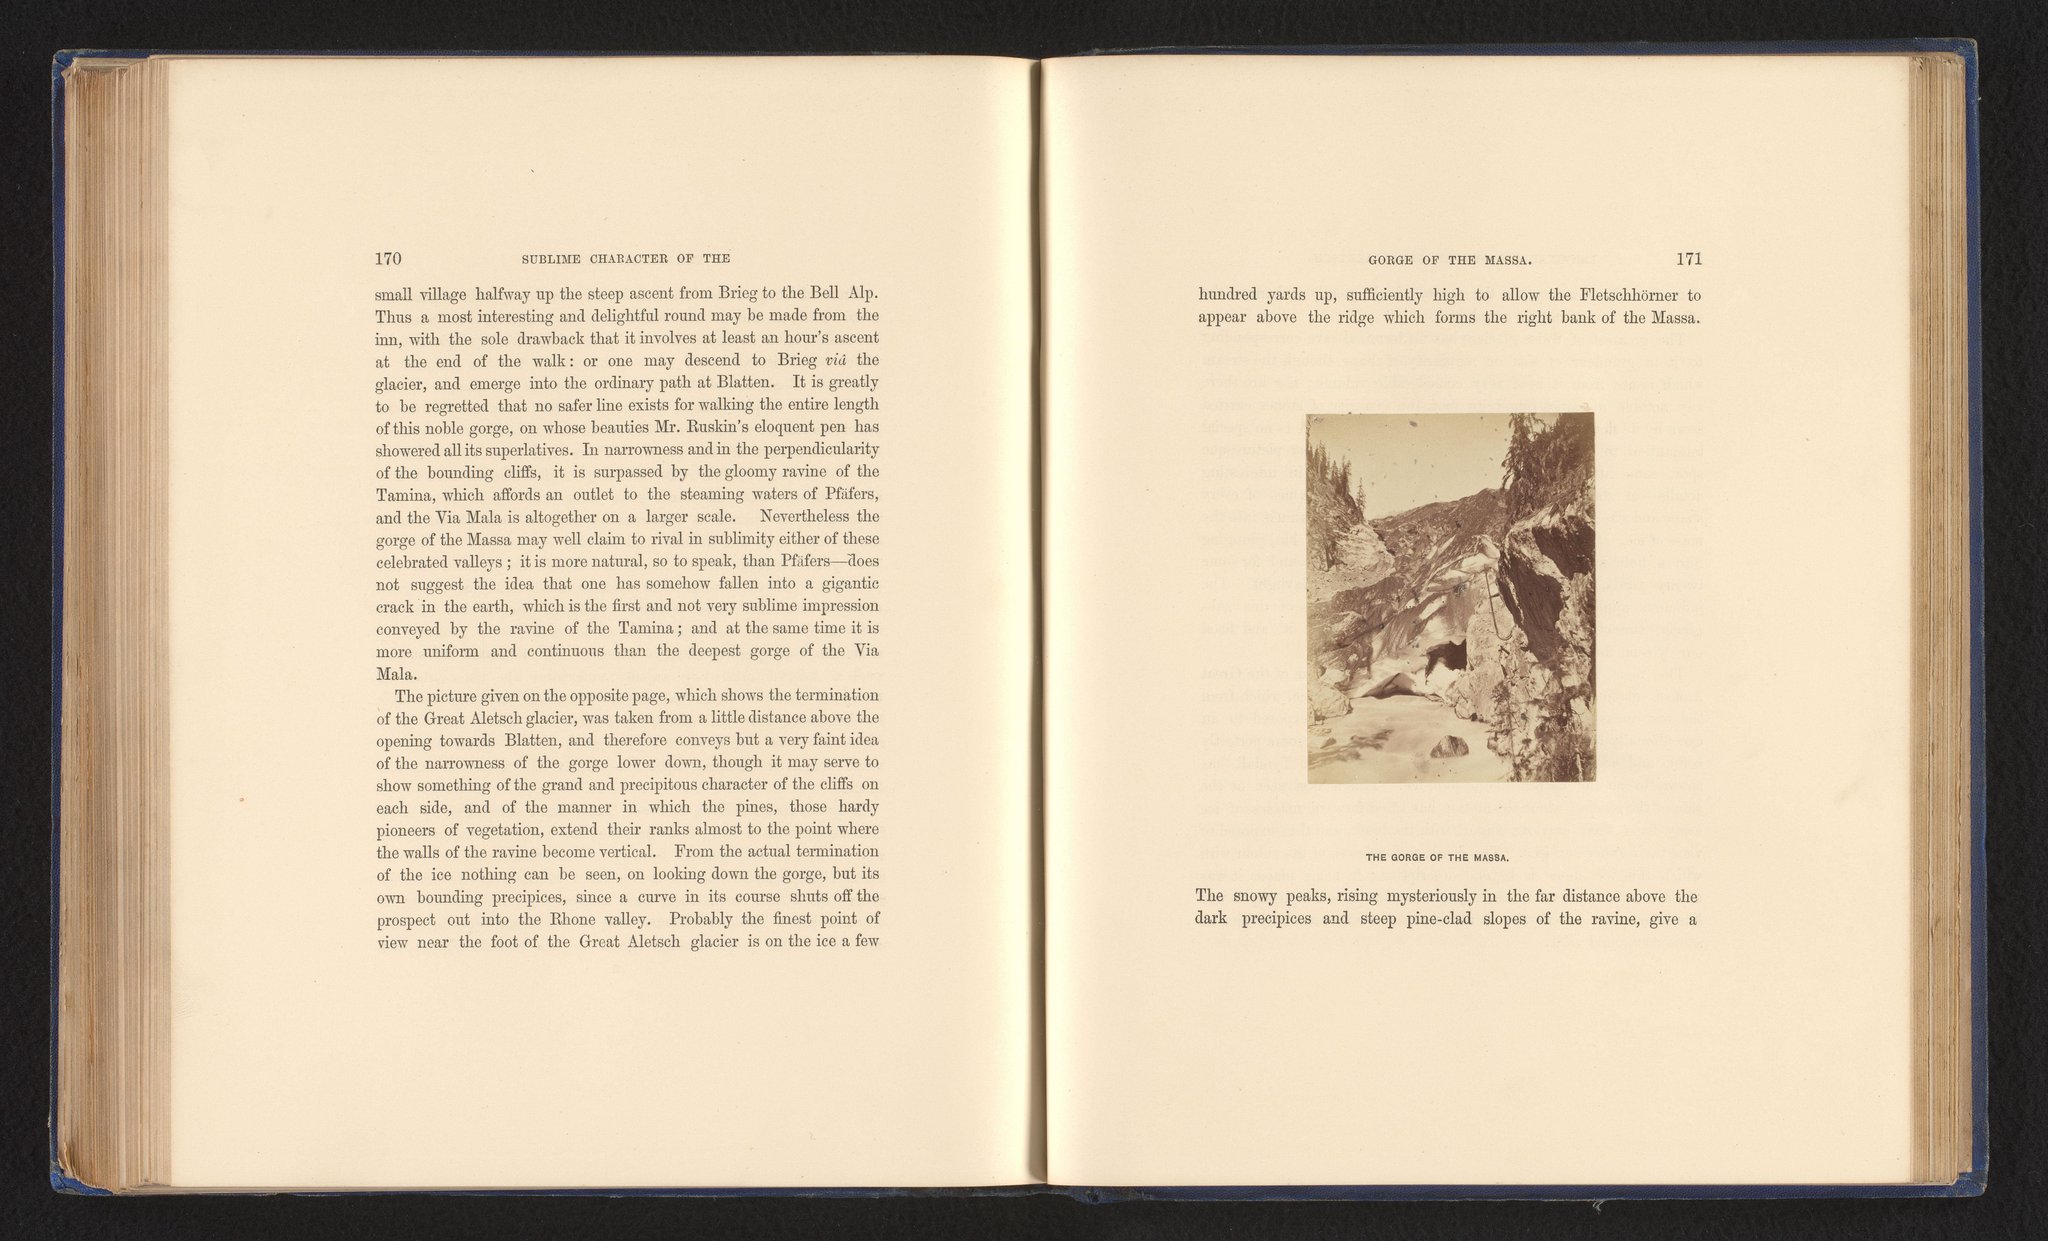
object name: photograph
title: The gorge of the Massa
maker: ernest edwards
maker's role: fotograaf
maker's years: 1837-1903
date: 1861-1866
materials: paper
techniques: albumen print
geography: berner alpen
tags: river